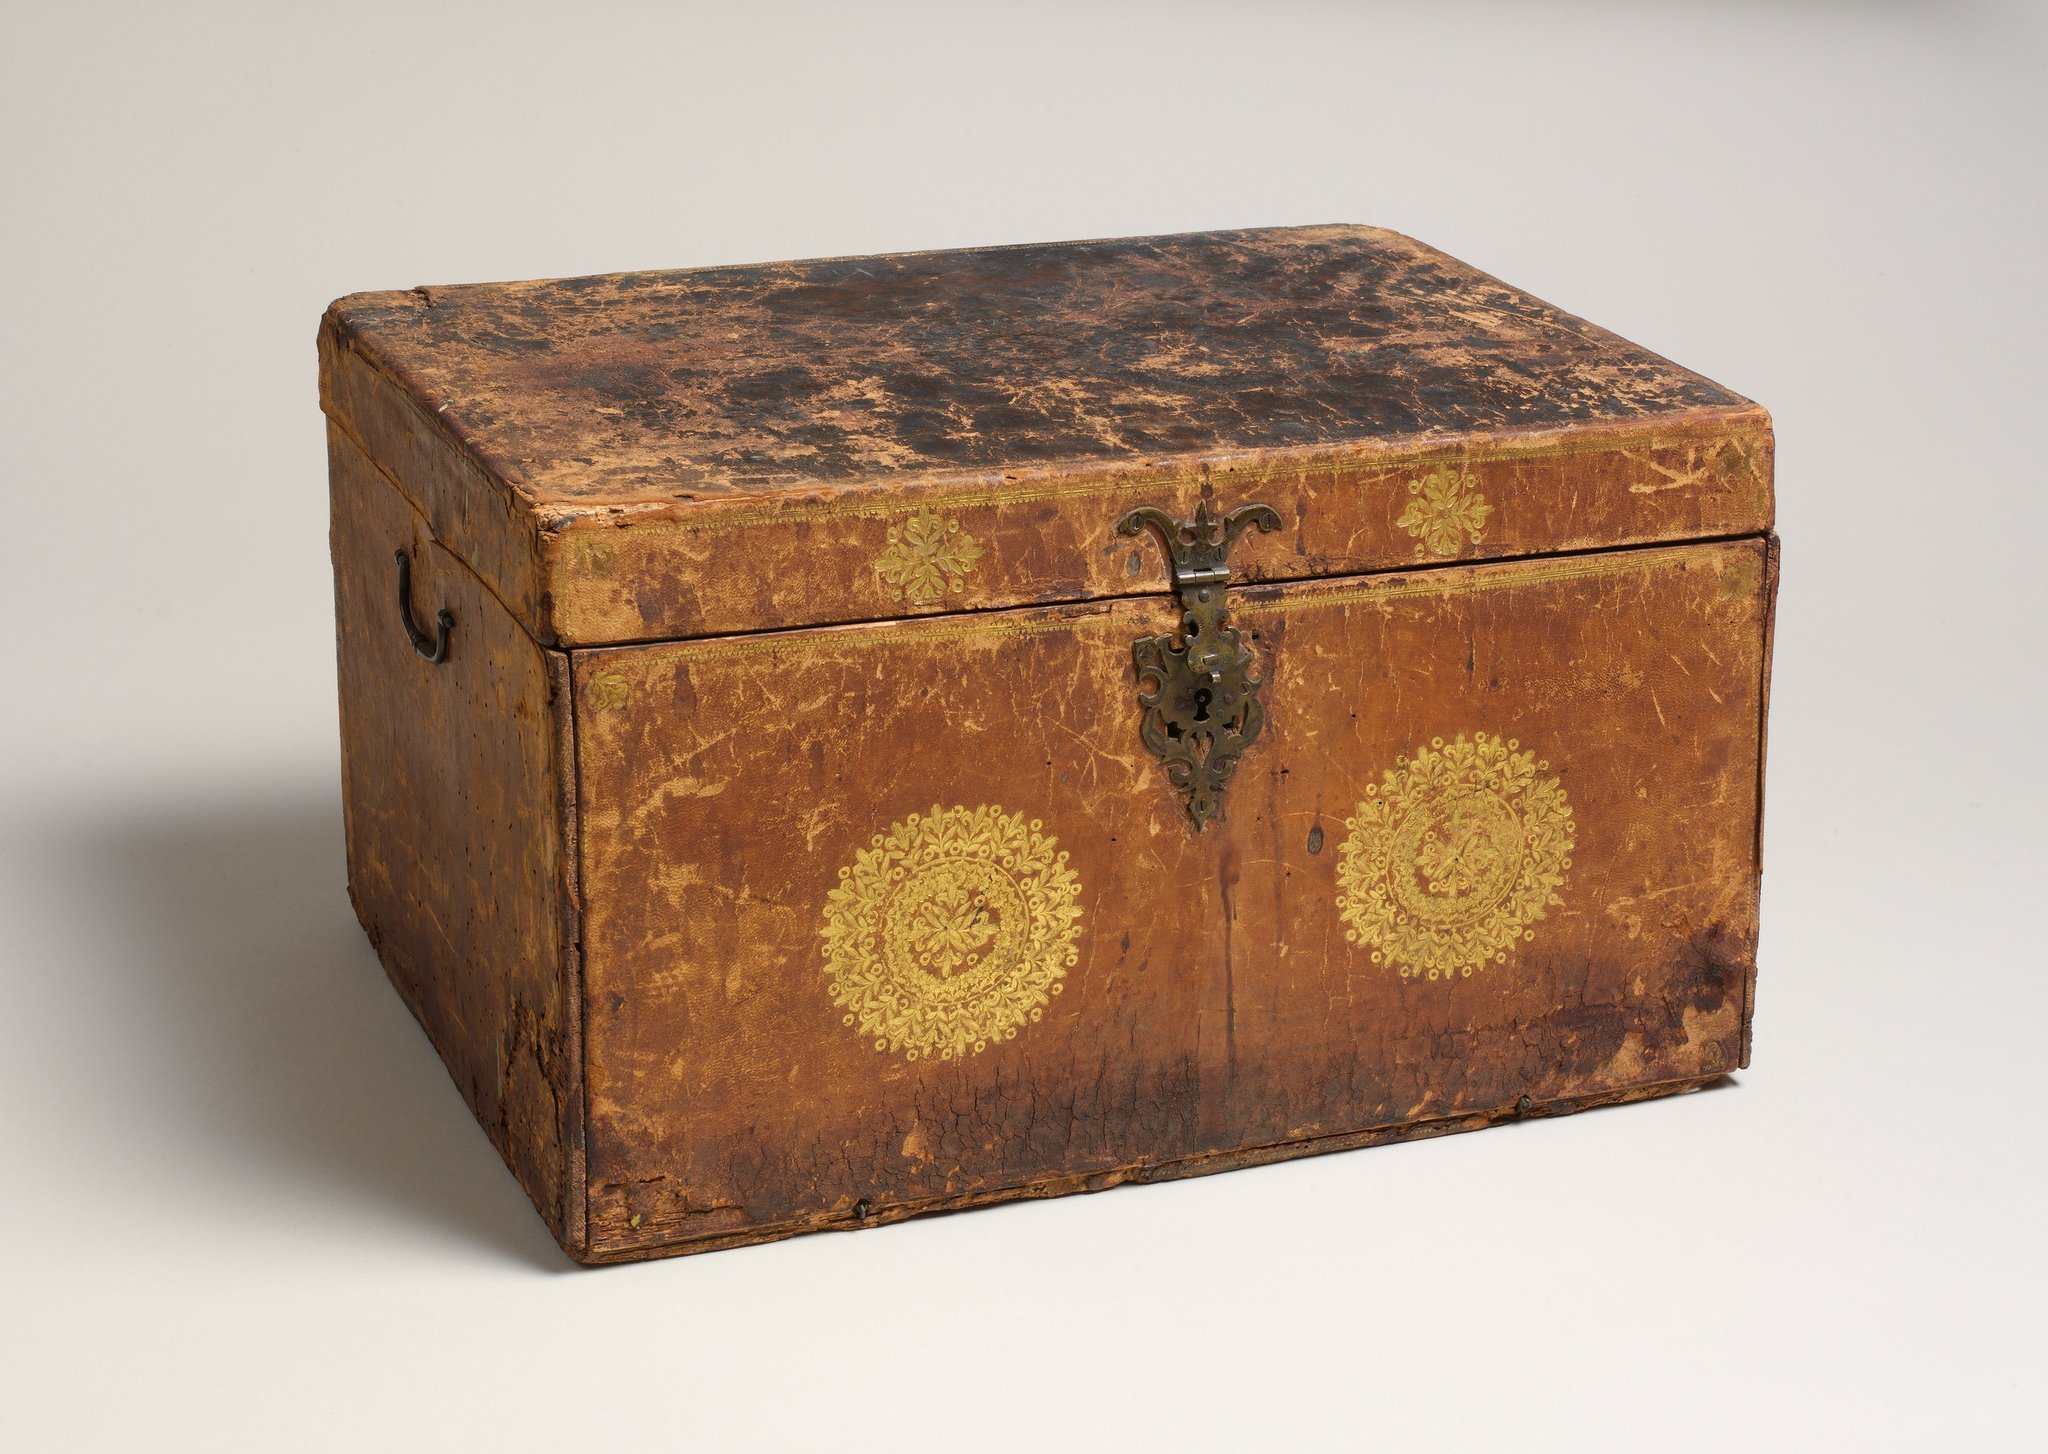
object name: casket box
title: Box for a casket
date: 1651-1675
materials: leather